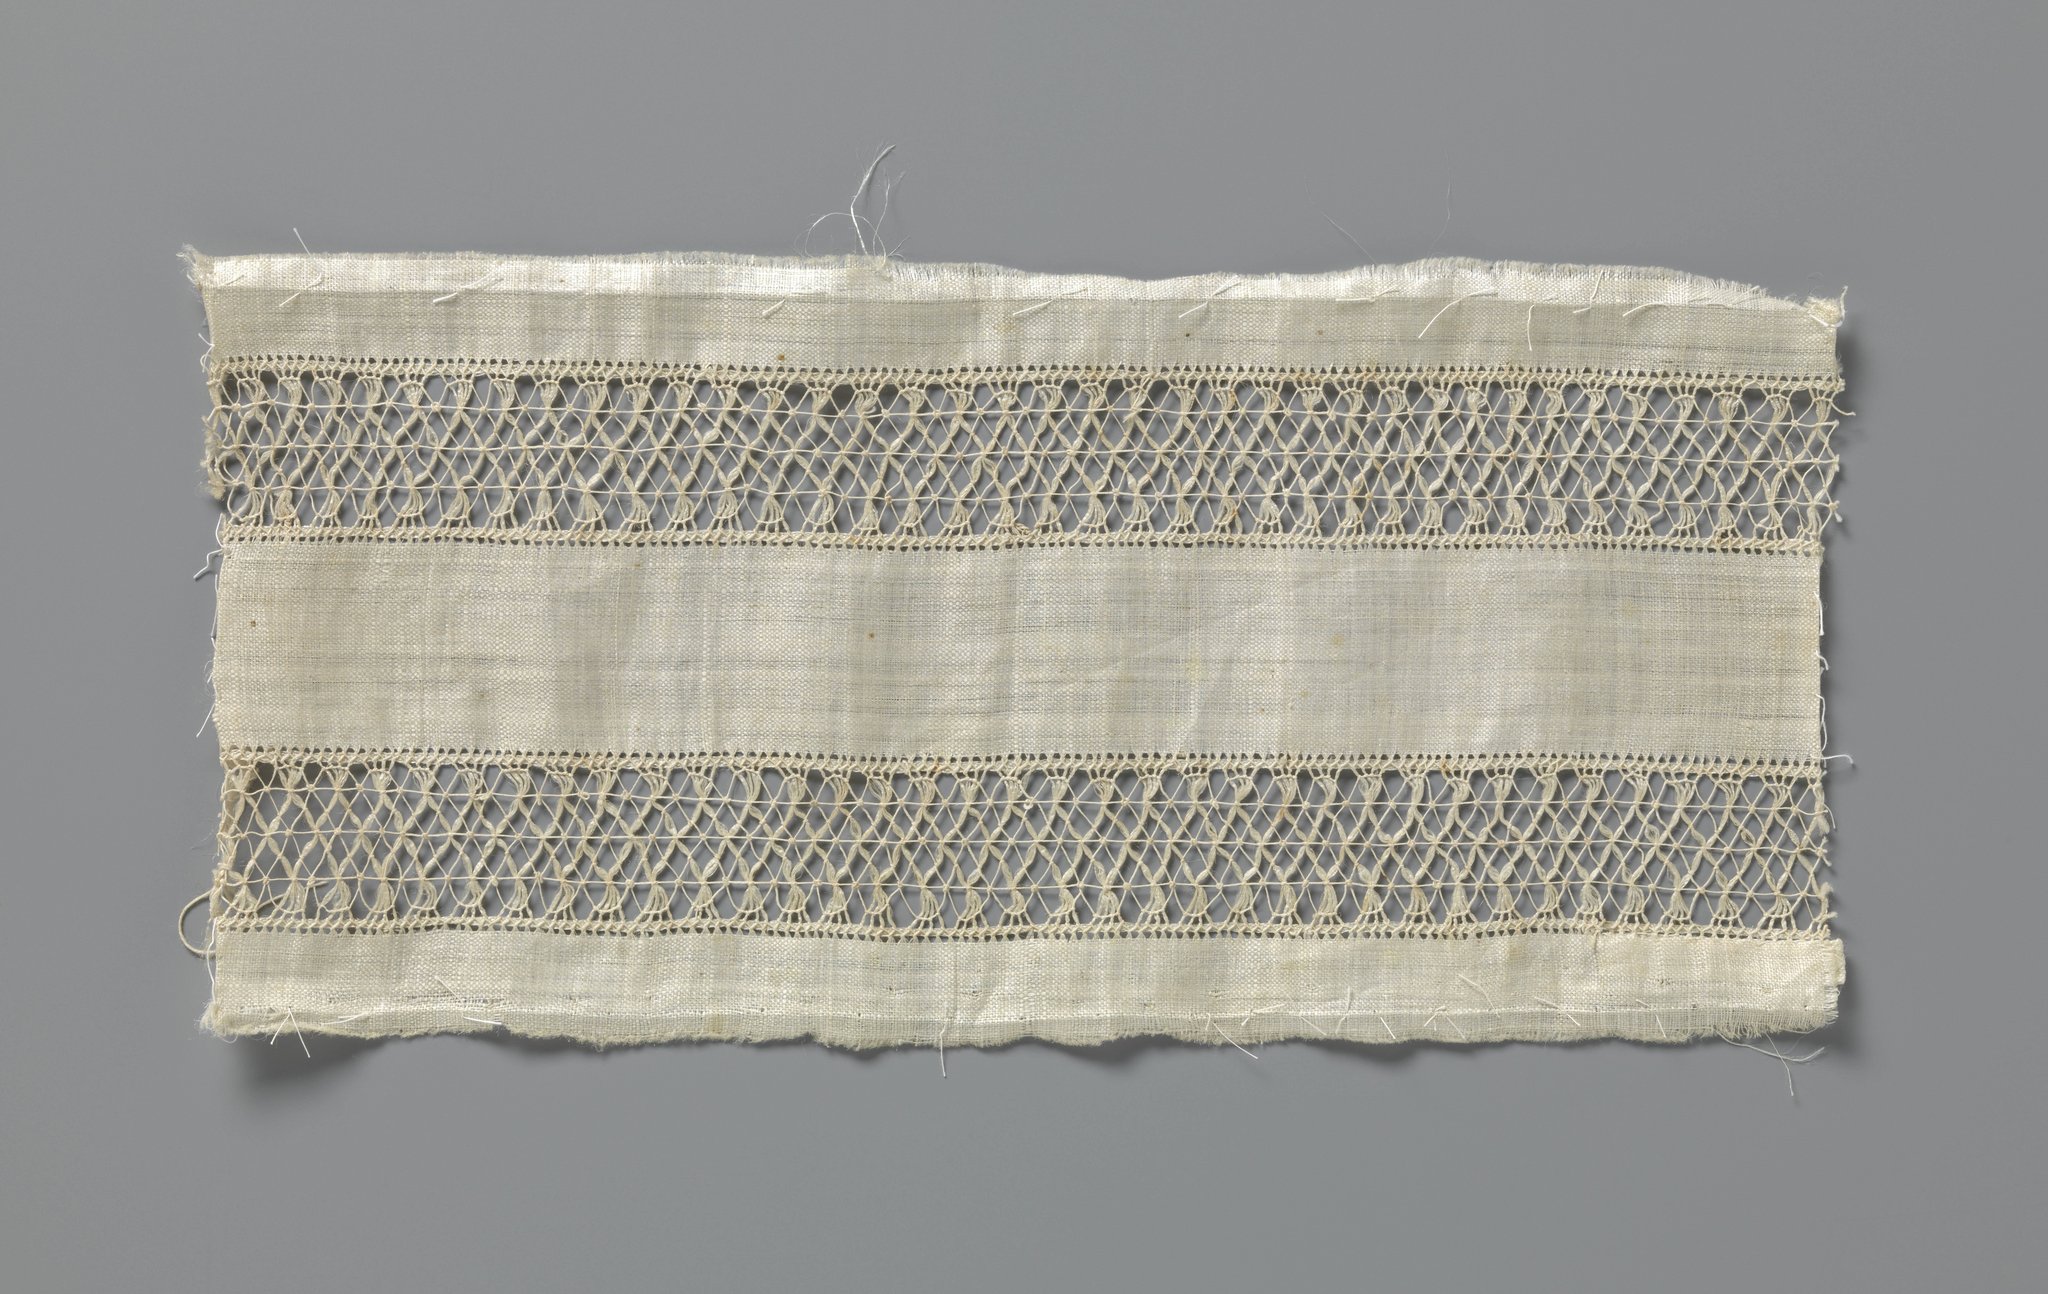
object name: strip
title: Strook textiel waarin twee kantstroken met ruitvormen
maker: Anonymous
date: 1900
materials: pineapple fiber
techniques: needle lace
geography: saba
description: Notitie bij de strook: "Het naaiwerk is een belangrijke huisindustrie op Saba (West-Indië). Het wordt vooral uitgevoerd naar de Verenigde Staten van Noord-Amerika, waar het goed betaald wordt."